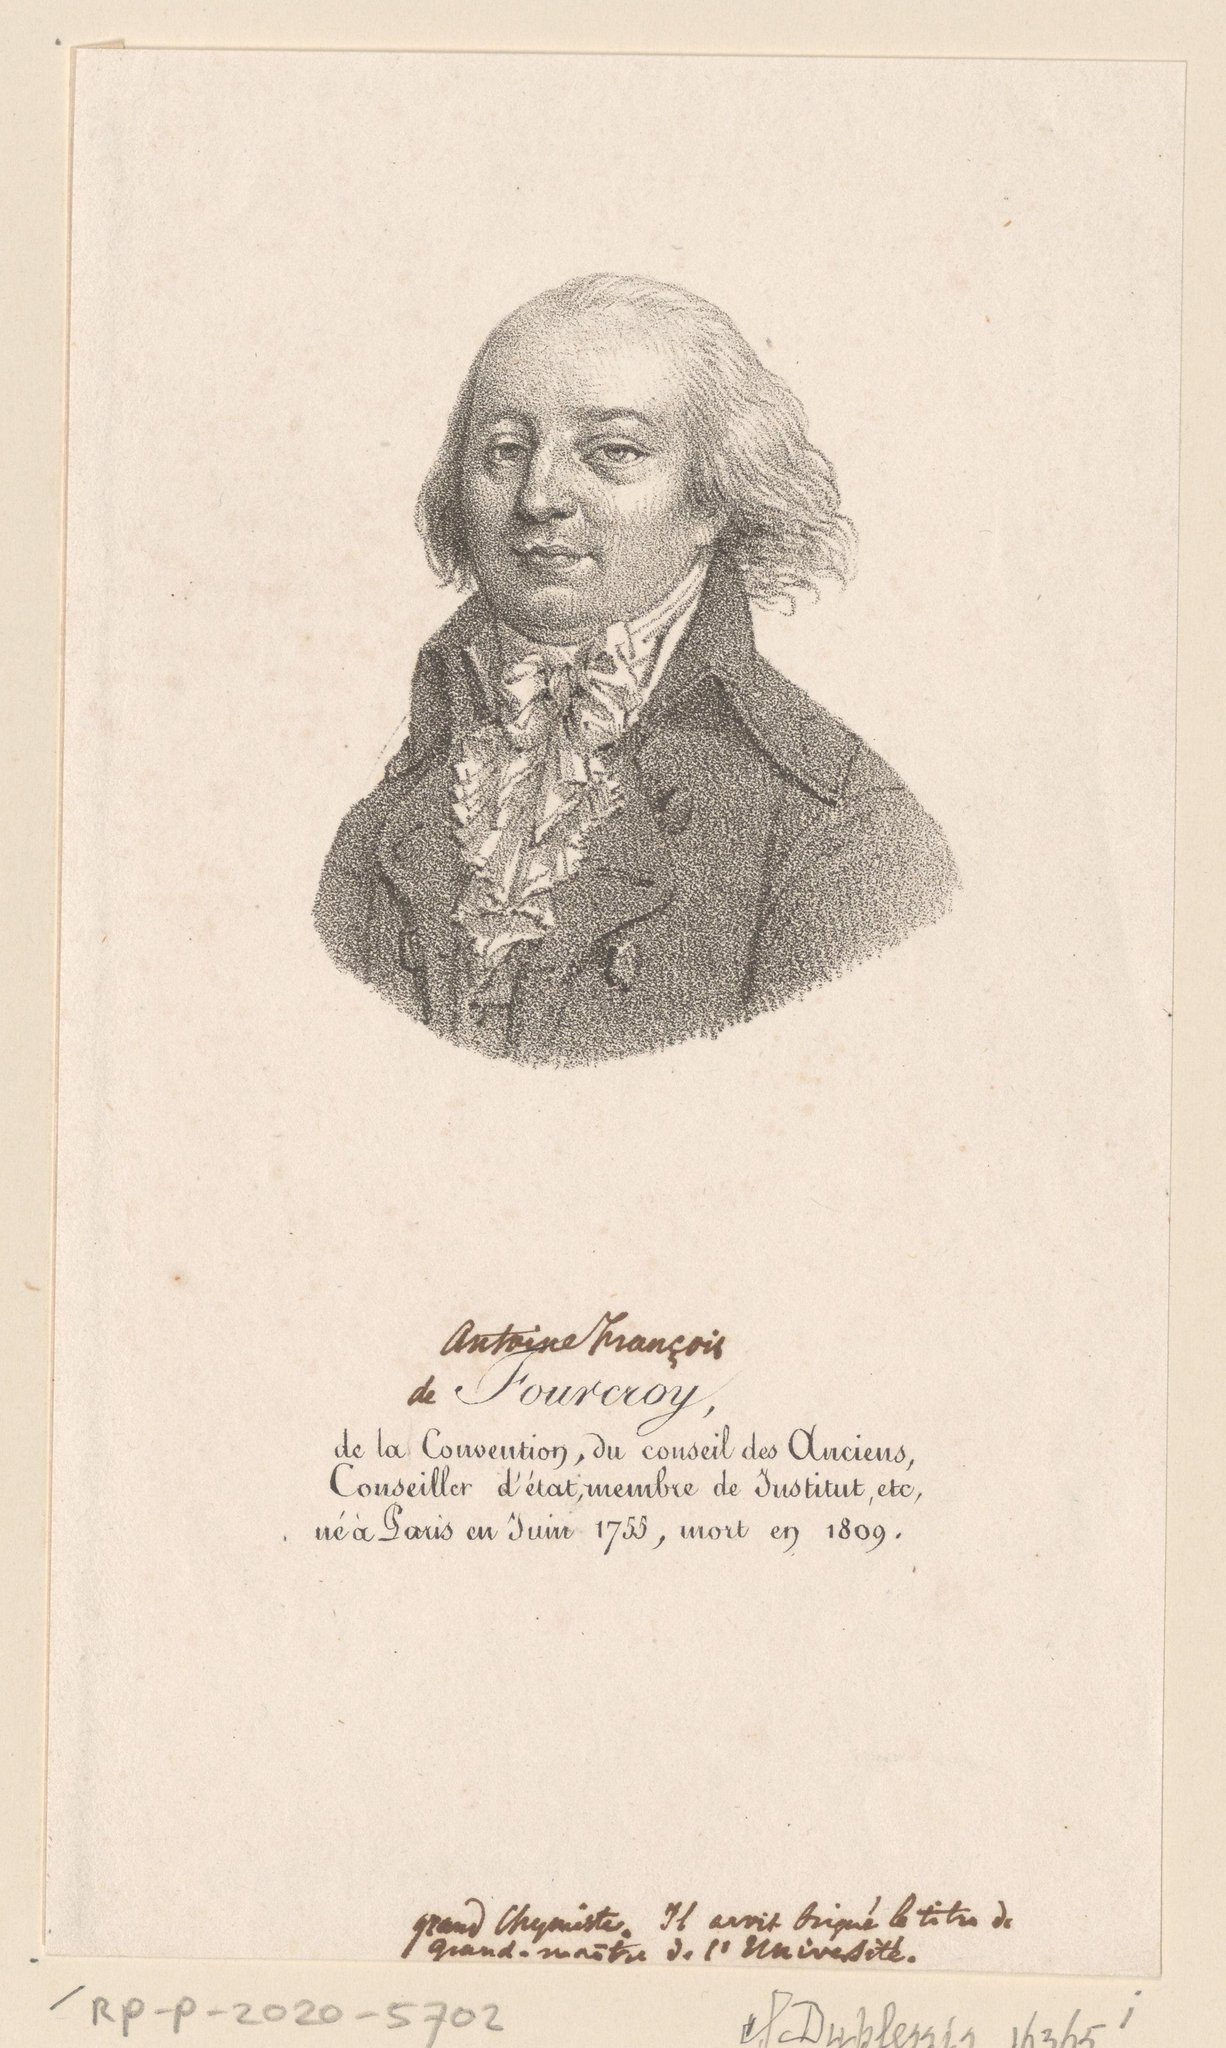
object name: book illustration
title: Portret van Antoine François de Fourcroy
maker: Anonymous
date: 1821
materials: paper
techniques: lithograph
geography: france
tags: paris, politician, historical persons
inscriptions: inscription: ‘Antoine François de [Fourcroy]’, inscription: ‘grand Chymiste (...)’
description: Prent waarschijnlijk uit: Choix de rapports, opinions et discours. Parijs: Alexix Eymery, 1821.